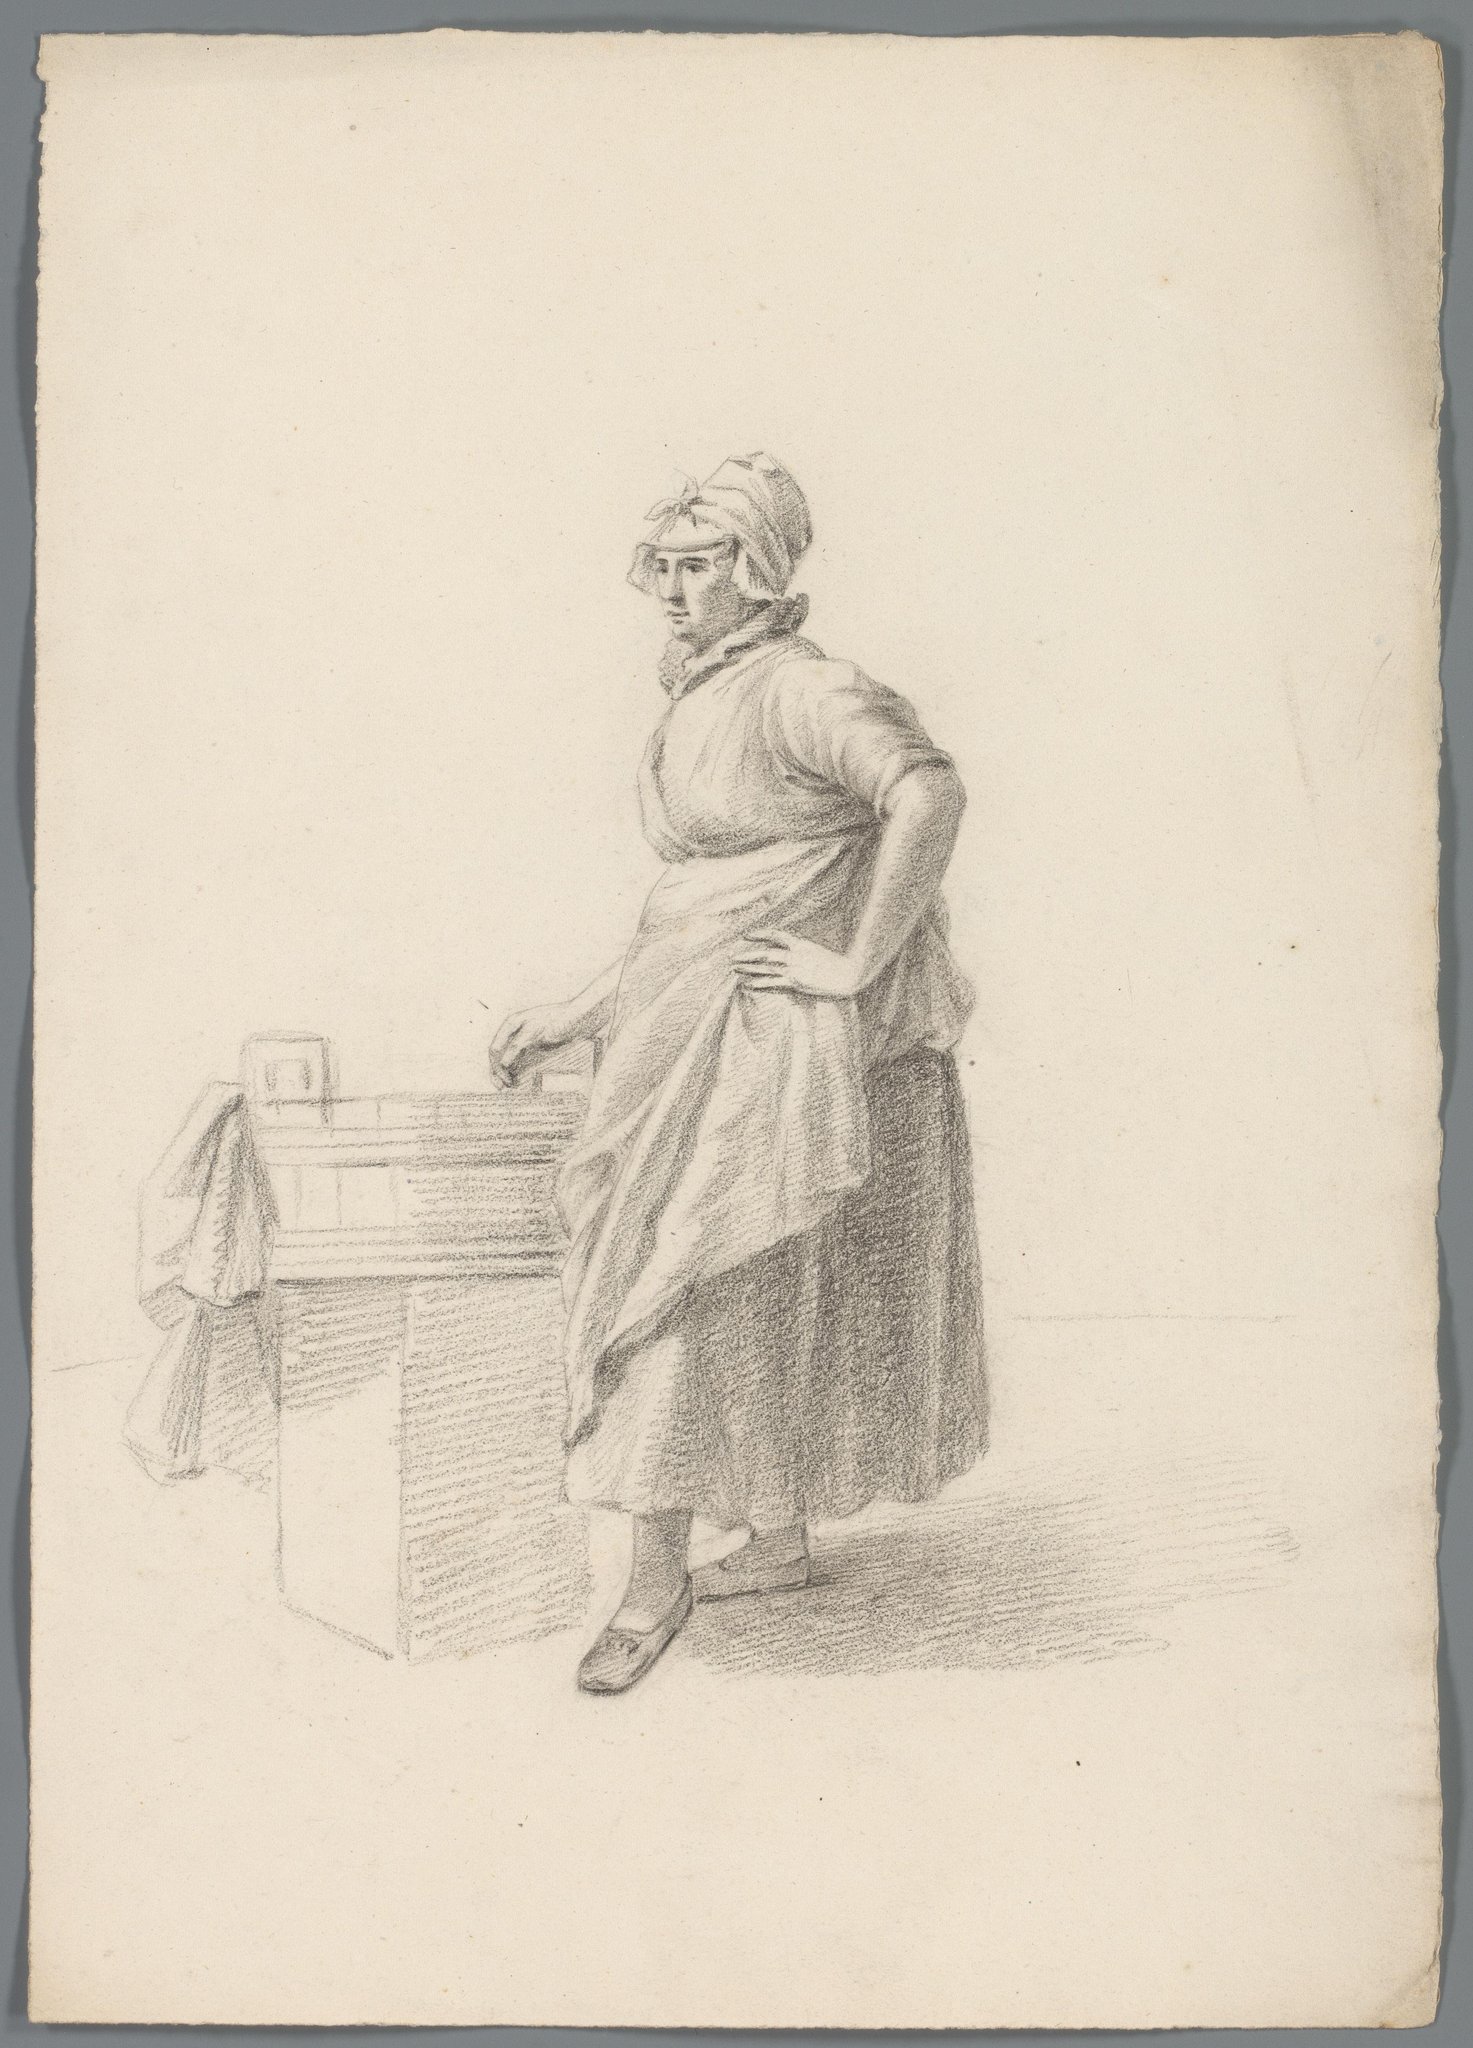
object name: drawing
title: Vrouw leunend op een tobbe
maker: Anonymous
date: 1820-1830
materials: chalk, paper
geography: the hague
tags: adult woman, household chores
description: Tekeningen waarschijnlijk ontstaan bij het Haagse kunstgenootschap ‘Tot Nut der Tekenkunst’, waar twee keer per week tekenavonden werden georganiseerd met geklede modellen.